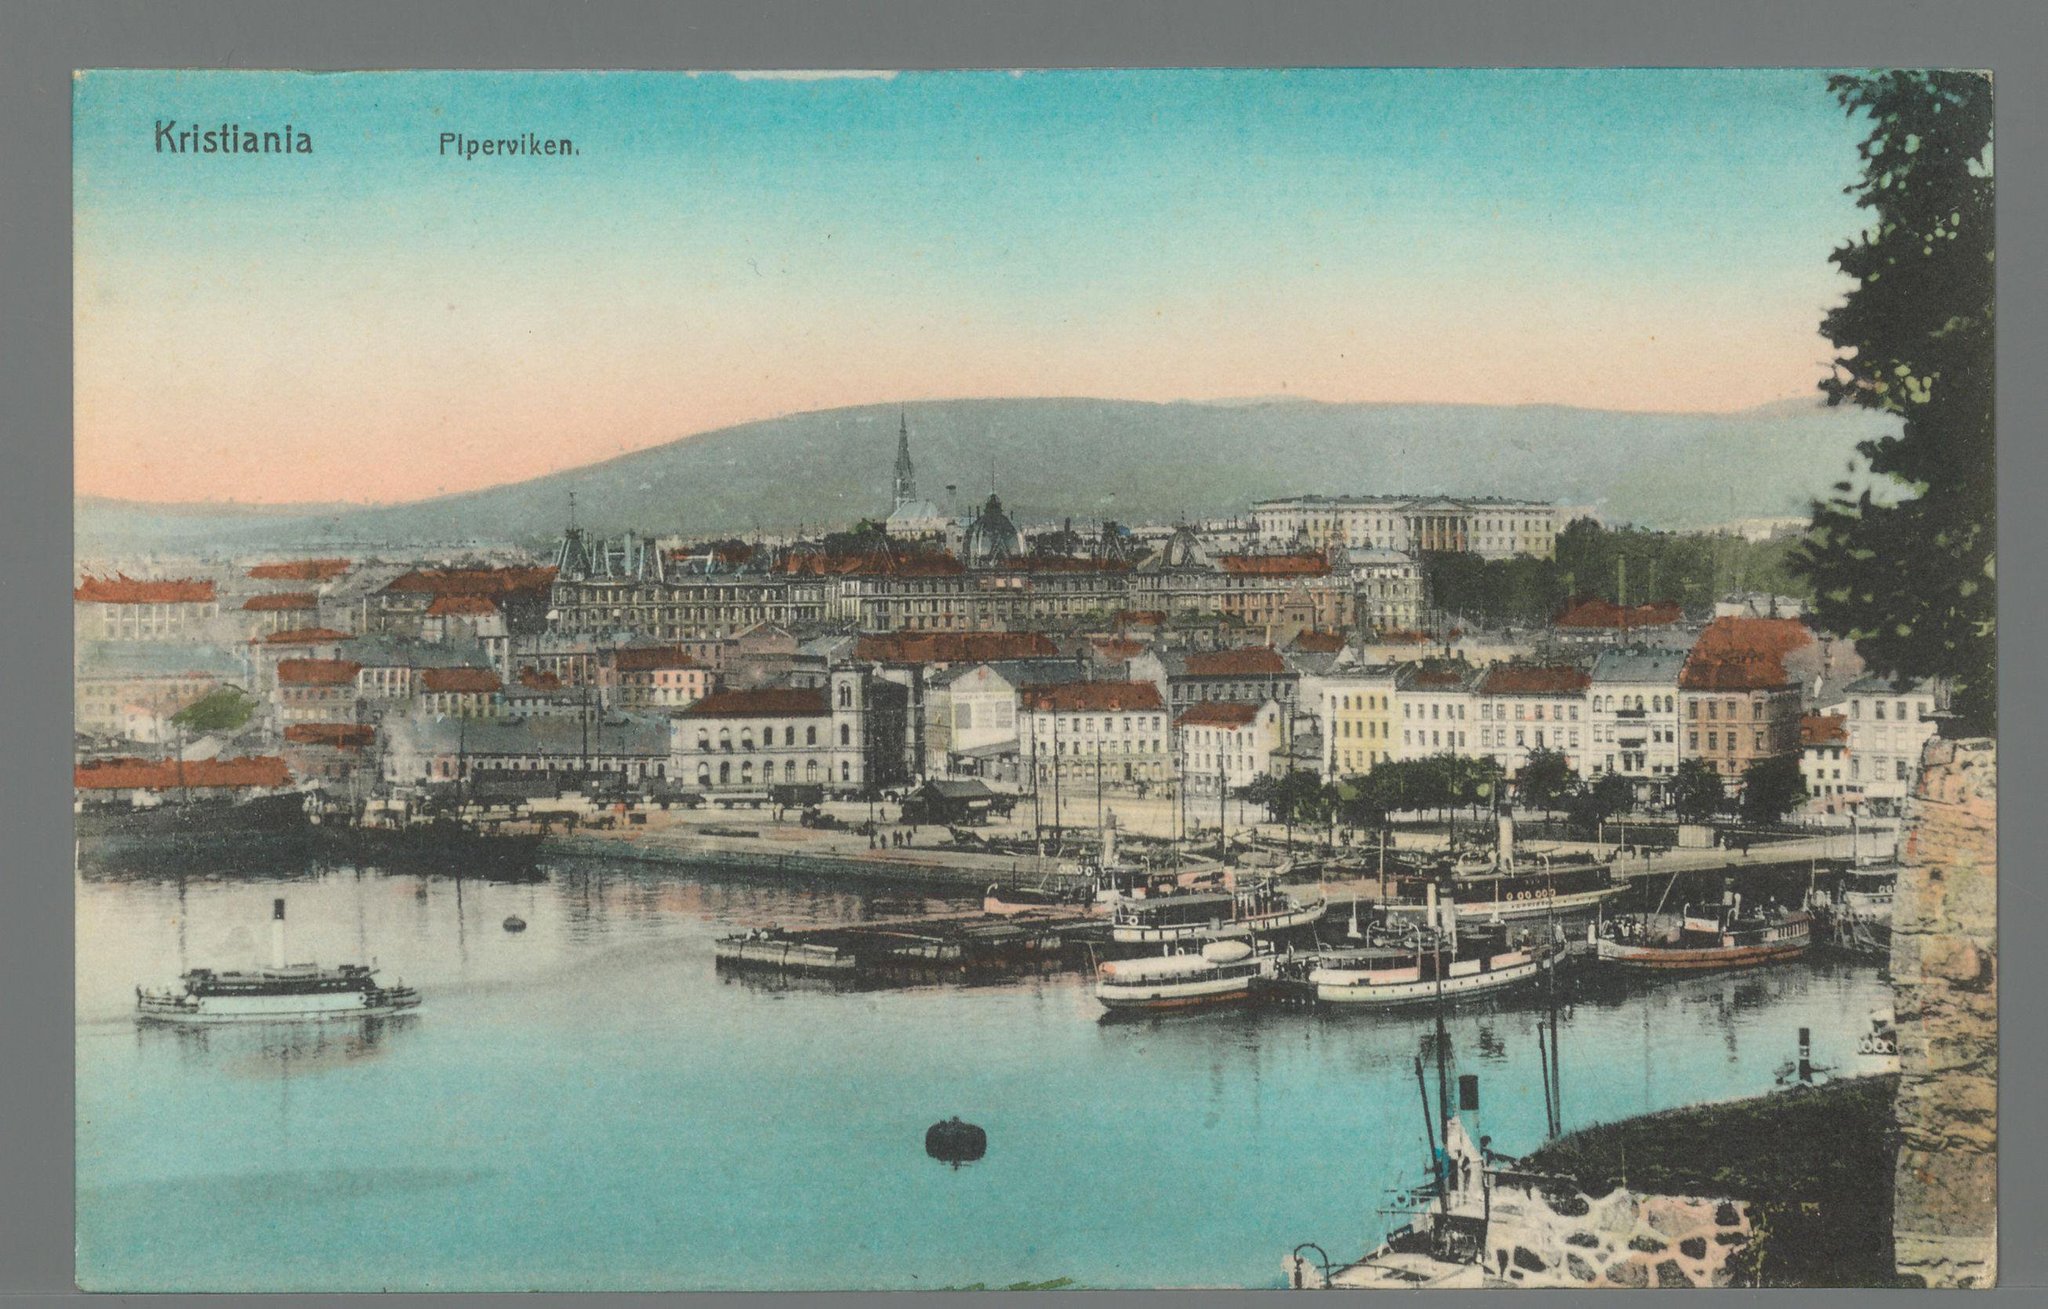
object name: ansichtkaart, prentbriefkaart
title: Kristiania. Plperviken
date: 1904-1930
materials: cardboard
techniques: photograph, lithograph, hand coloring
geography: hamburg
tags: harbour, city-view, and landscape with man-made constructions